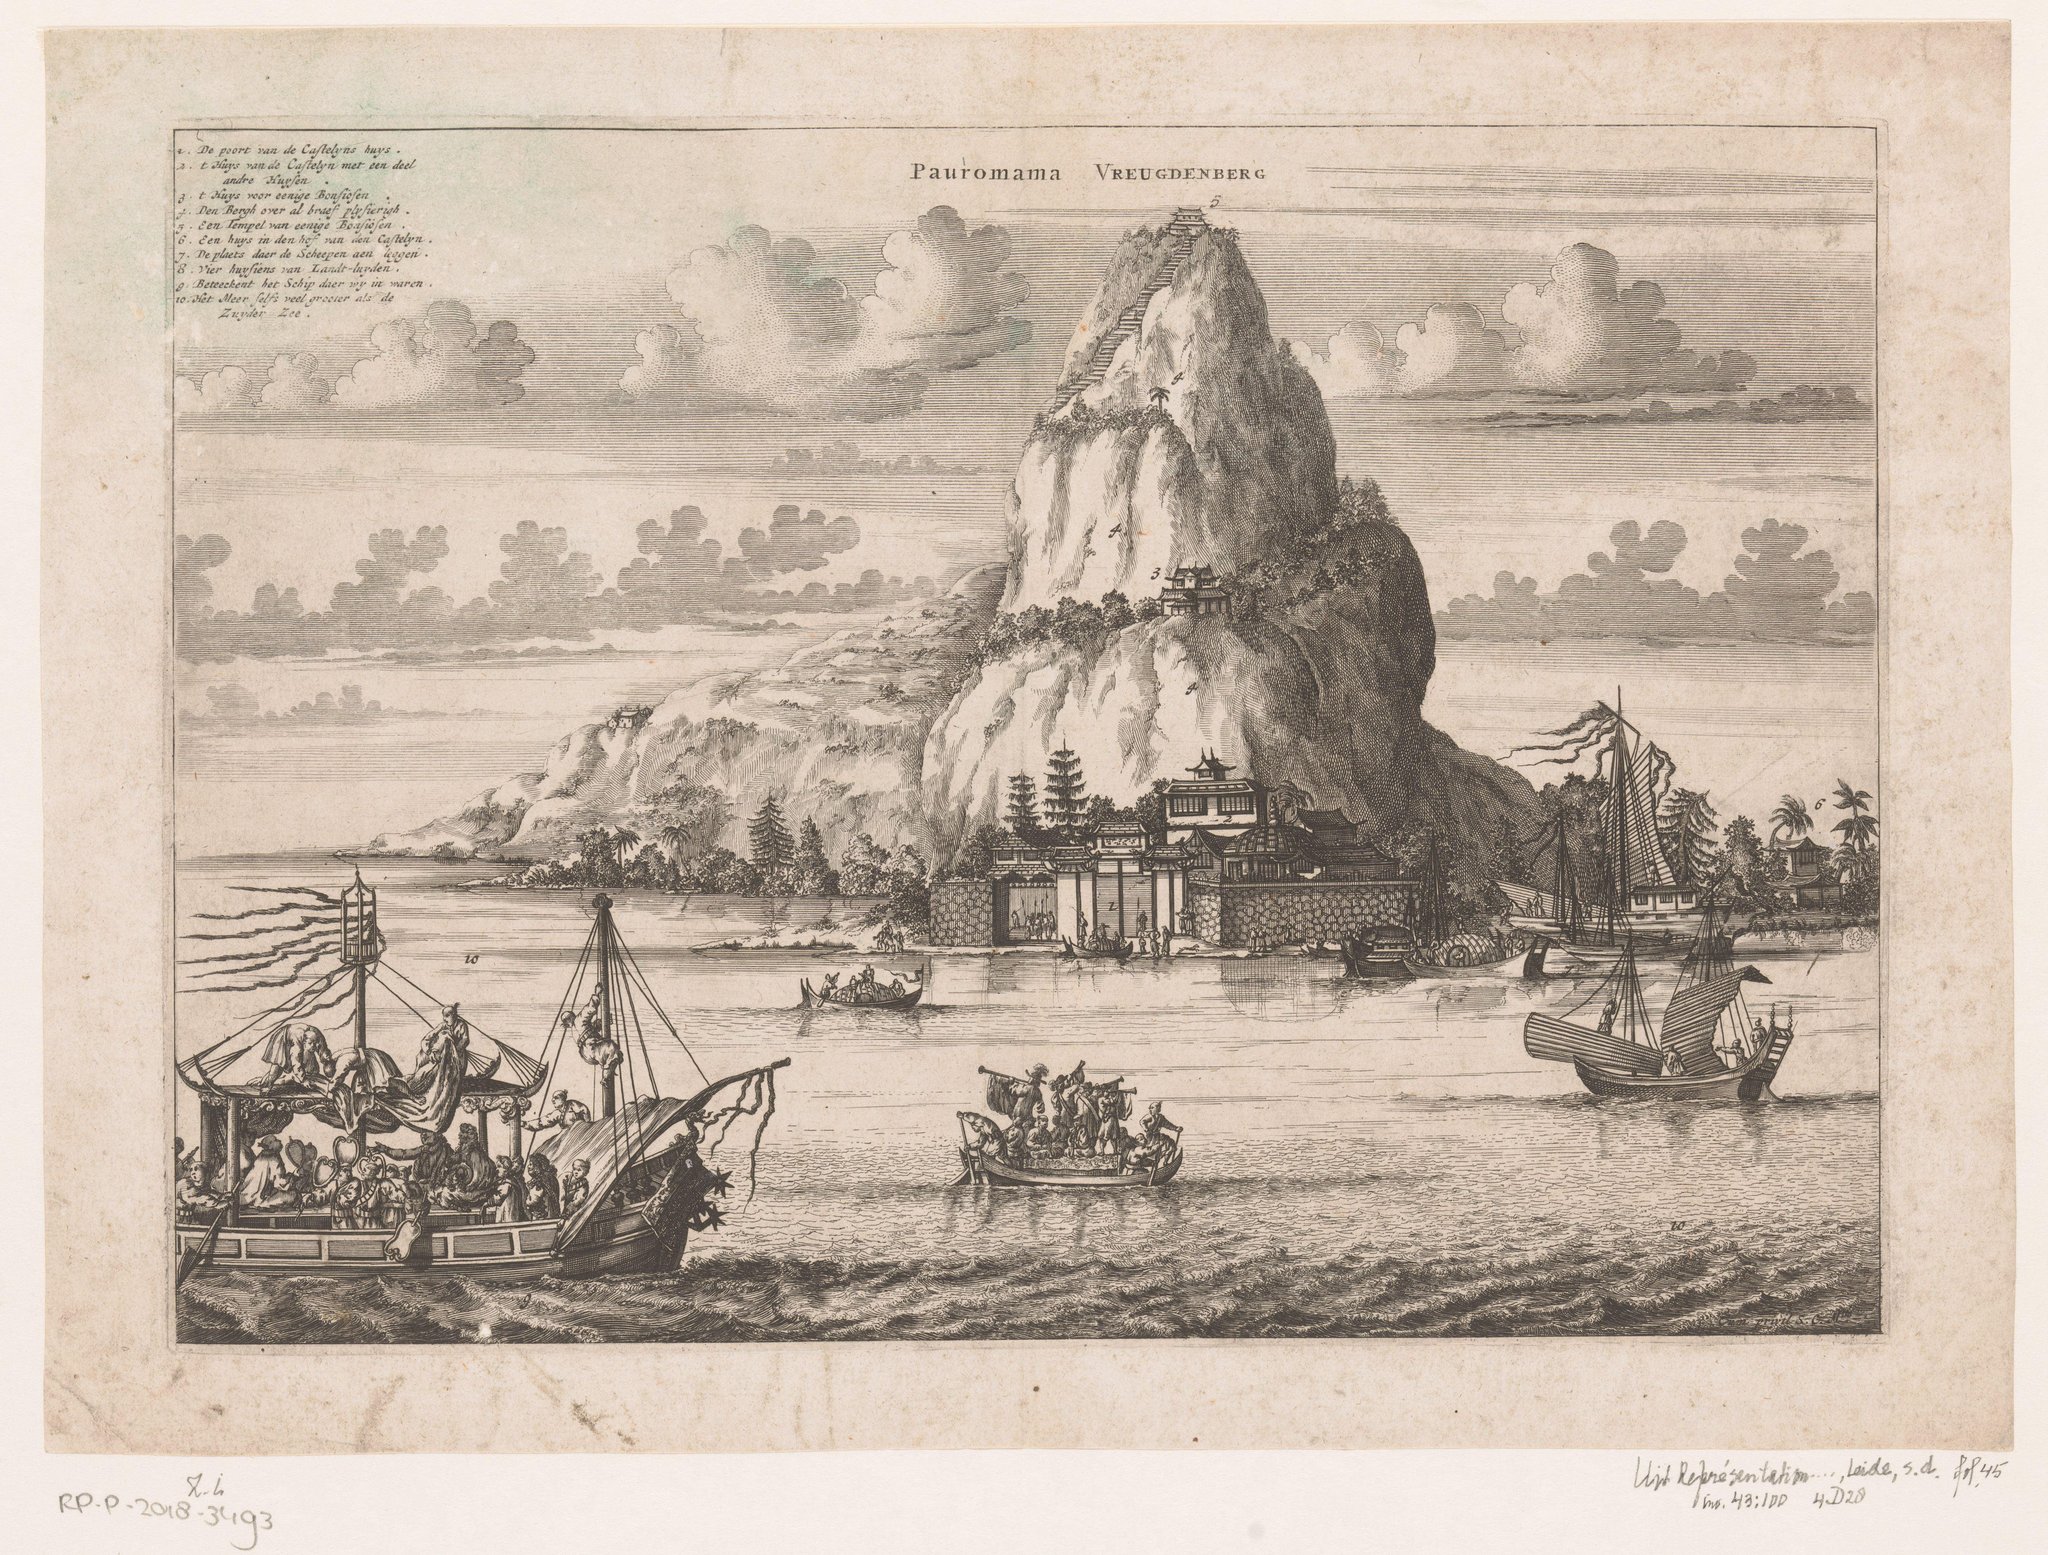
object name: book illustration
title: Pauromama / Vreugdenberg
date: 1669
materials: paper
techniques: engraving, etching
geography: amsterdam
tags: inn, coffee-house, public house, etc., mountains, japan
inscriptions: collector's mark: Lugt 2228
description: Een Japans schip met daarop de Nederlandse delegatie, voorafgegaan door een kleine boot met daarin Nederlanders die op trompetten blazen, arriveert bij de berg Pauromama in Japan. Een legenda linksboven duidt enkele plaatsen op de prent.